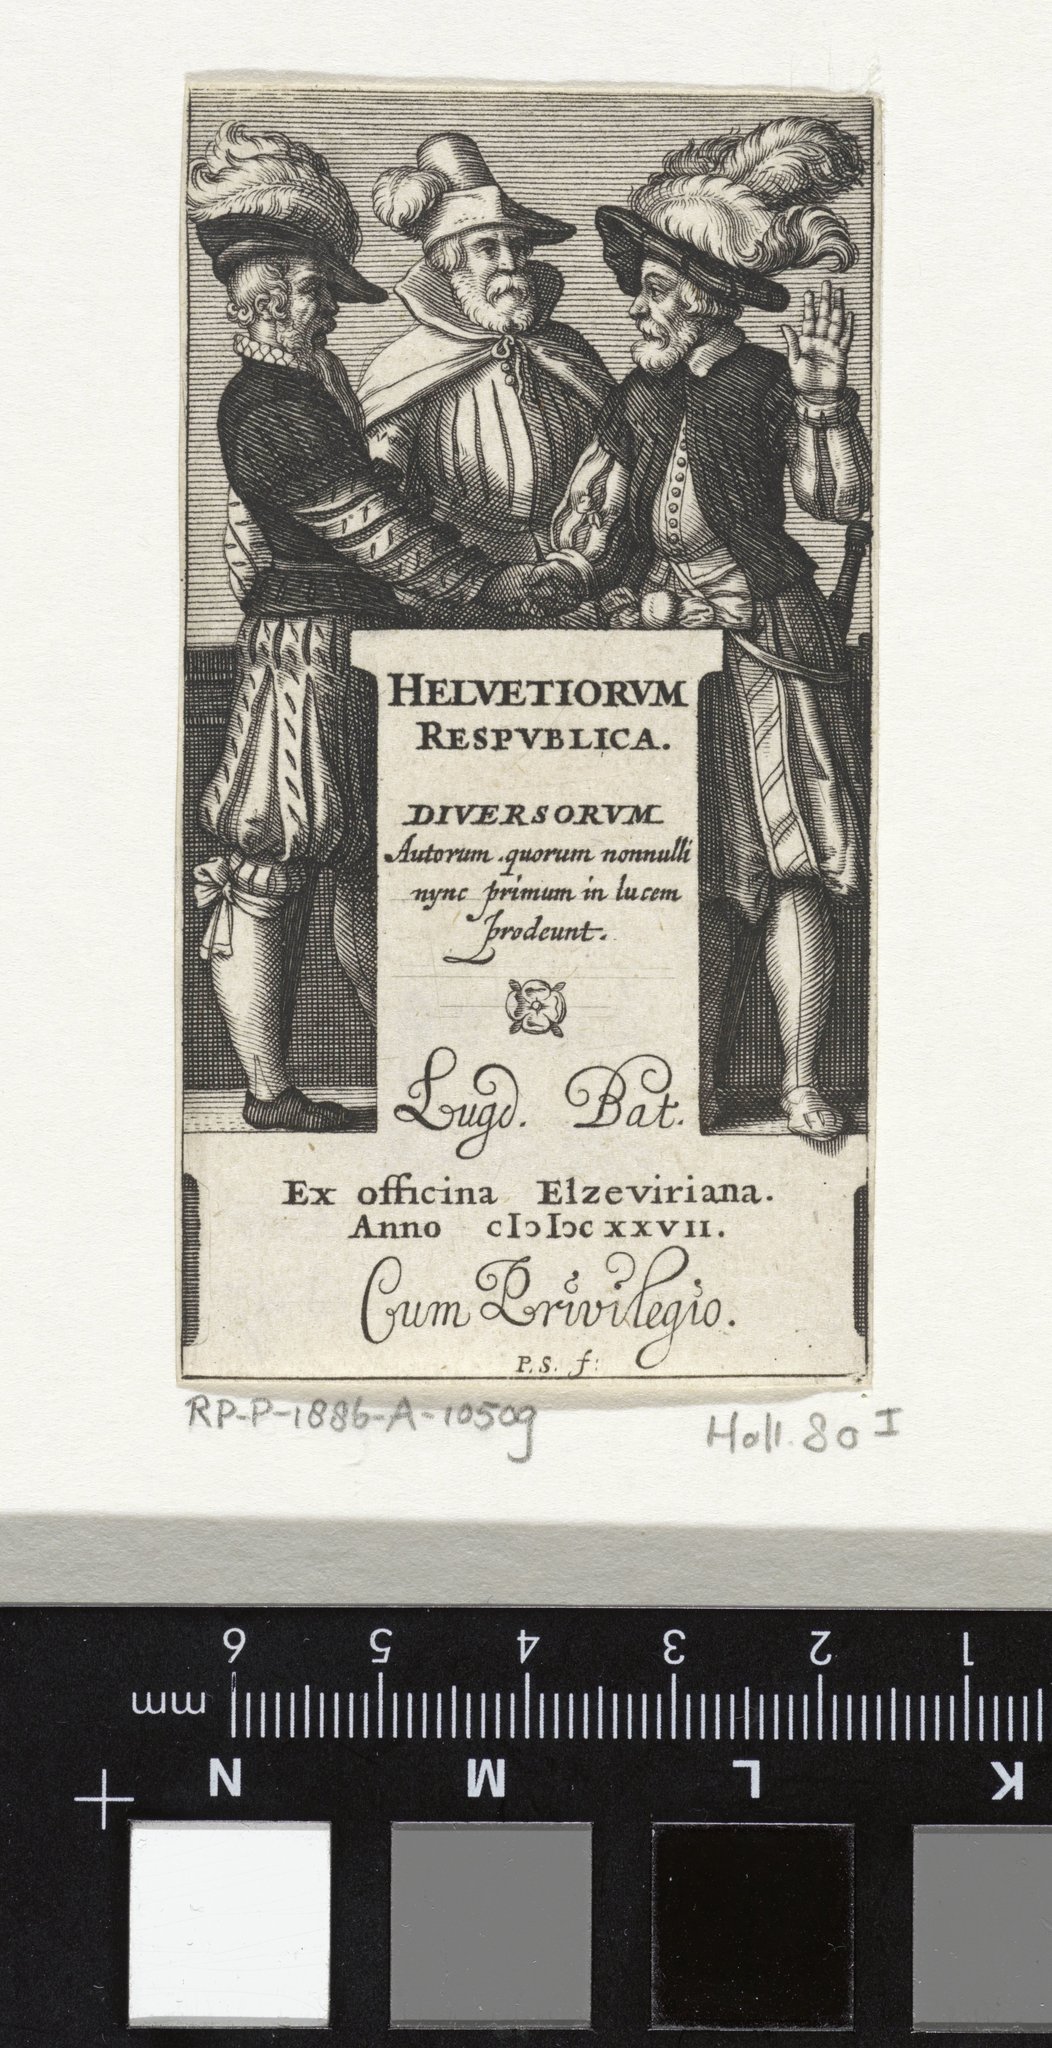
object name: print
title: Titelpagina van Helvetiorum Respublica, 1628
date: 1628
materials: paper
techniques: engraving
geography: leiden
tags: europeans (with name)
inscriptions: date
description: Twee Zwitserse mannen schudden elkaar de hand, waarbij er een zijn andere hand opsteekt. Een derde man kijkt toe. Zij staan bij een voetstuk, waarop de titel van het boek weergegeven staat, met daaronder het impressum.